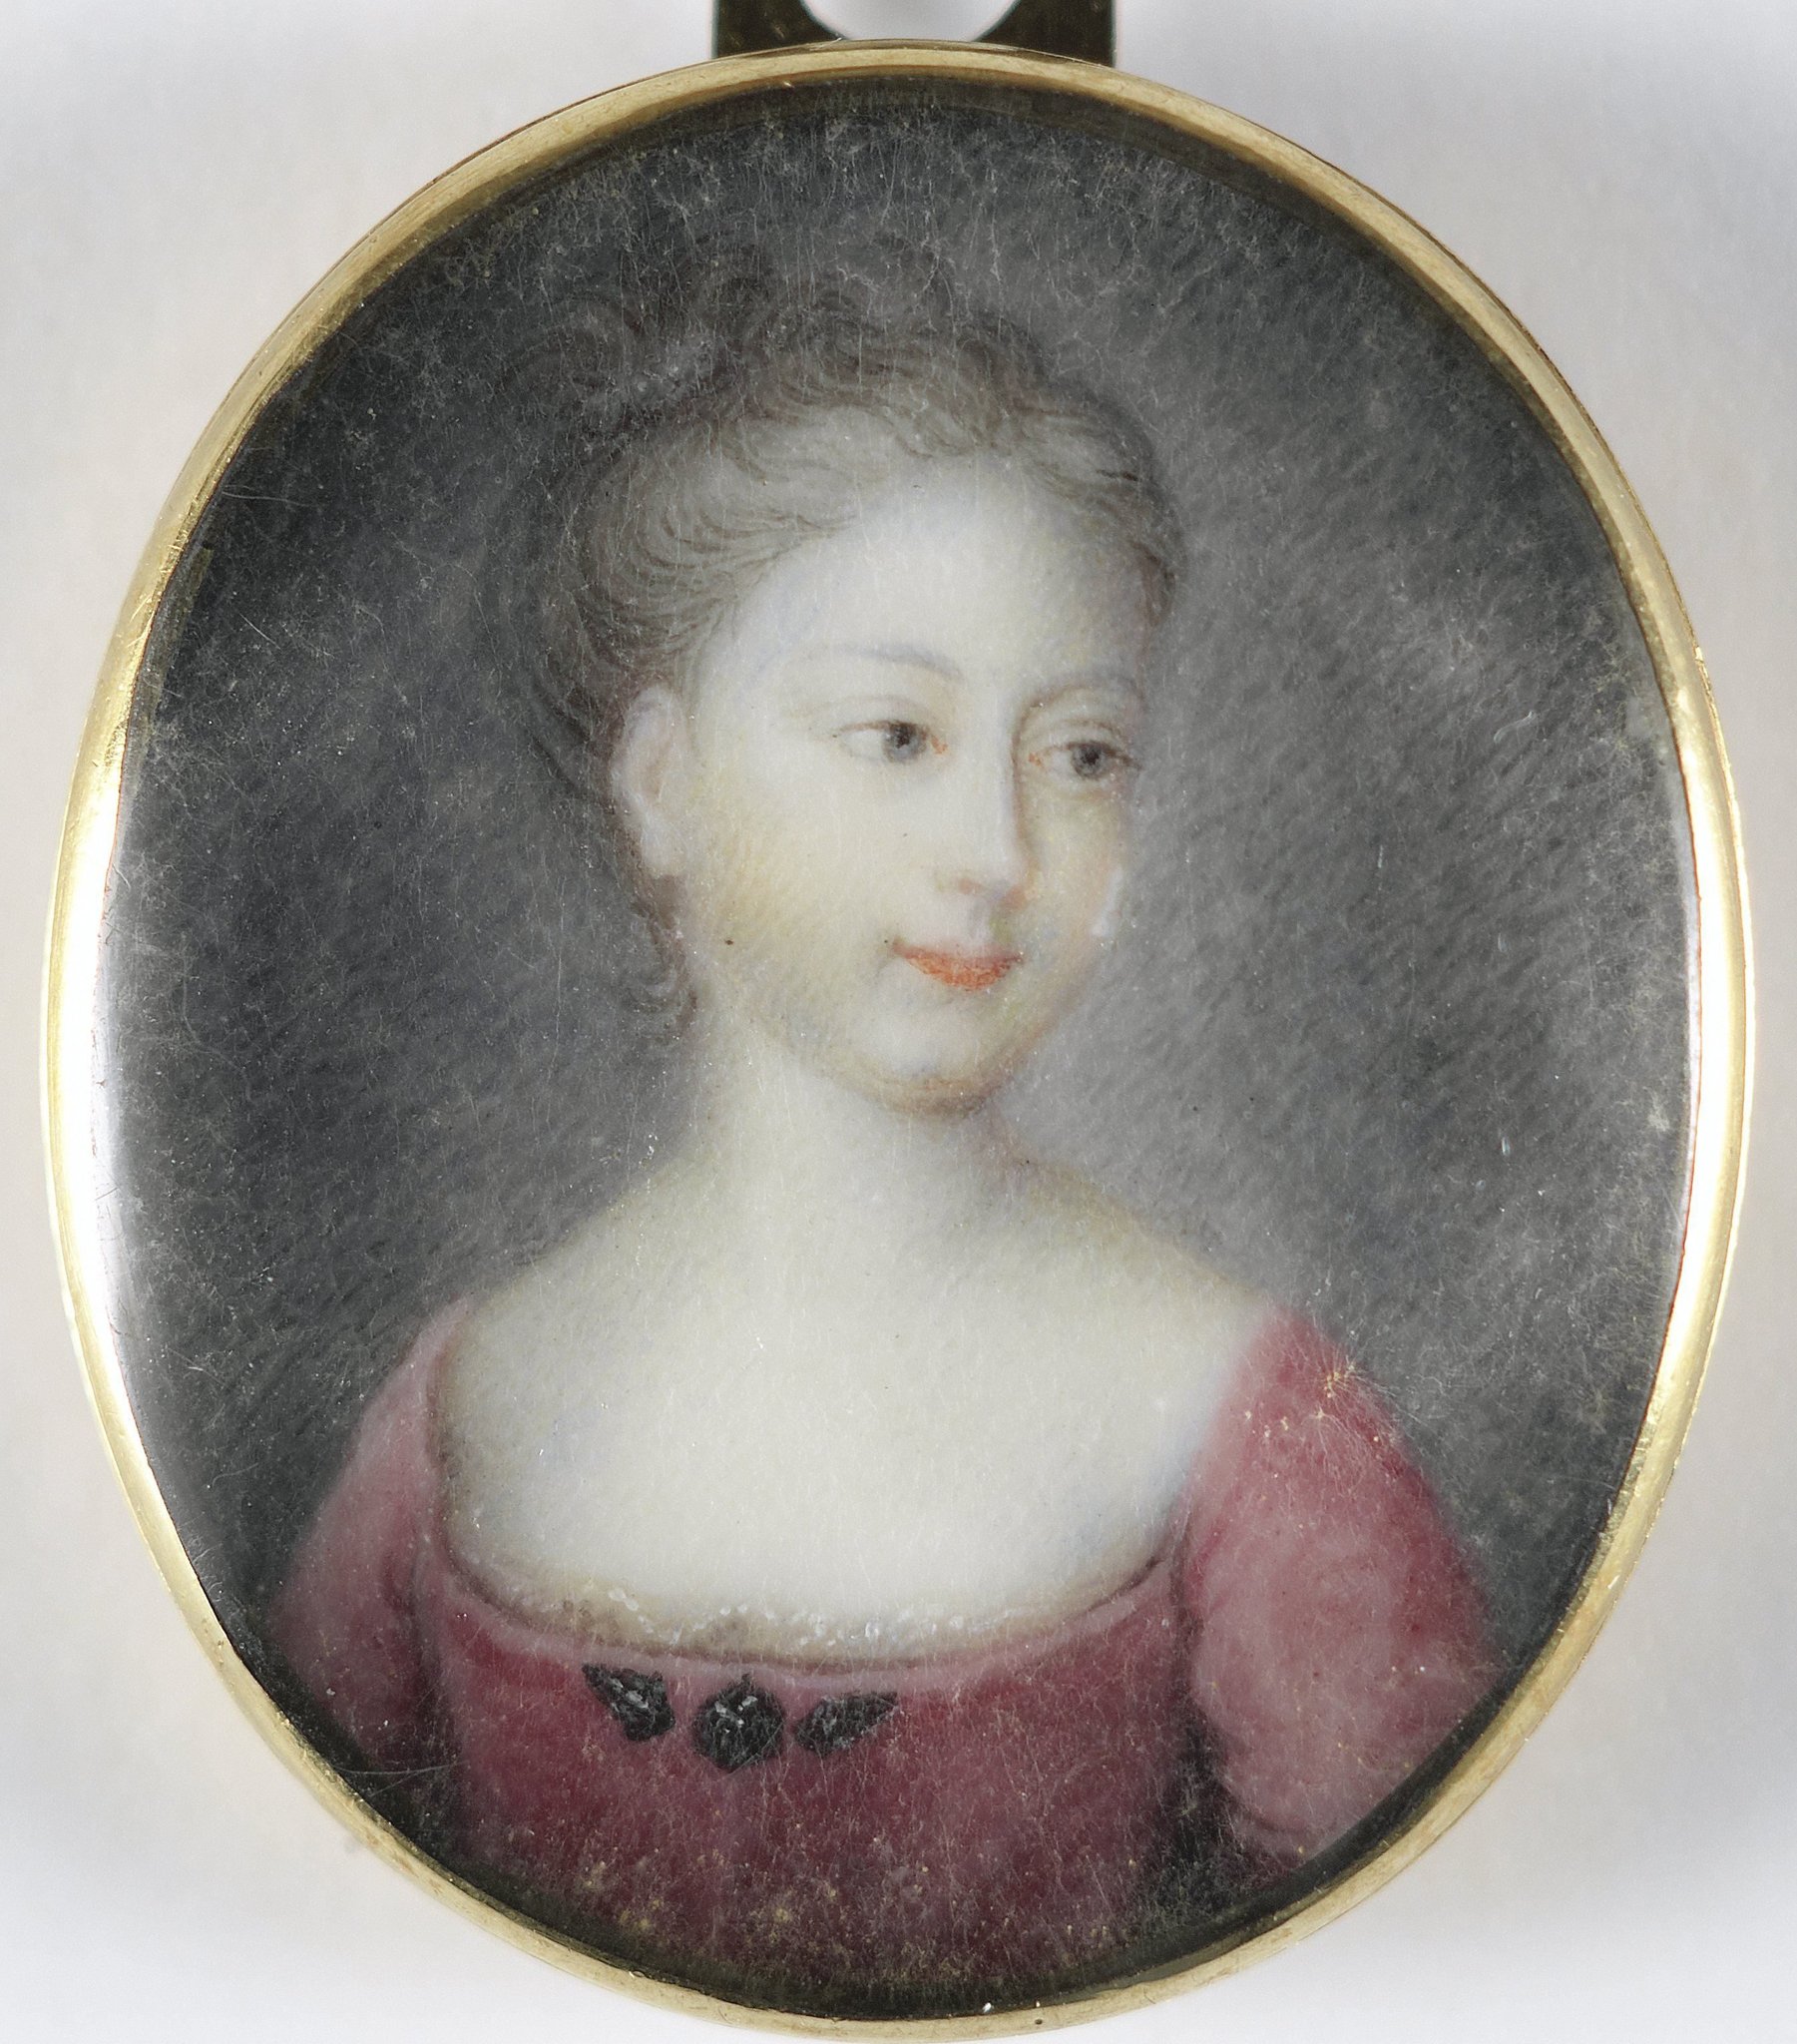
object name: painting, miniature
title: Portret van een meisje, vermoedelijk een dochter van George II, koning van Engeland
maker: Anonymous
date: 1715-1725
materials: glass, ivory, metal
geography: england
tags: the hague, anna van hannover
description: Portret van een meisje, vermoedelijk een dochter van George II, koning van Engeland (misschien Anna van Hannover (1709-59), de toekomstige echtgenote van prins Willem IV). Buste, naar rechts. Onderdeel van de collectie portretminiaturen.